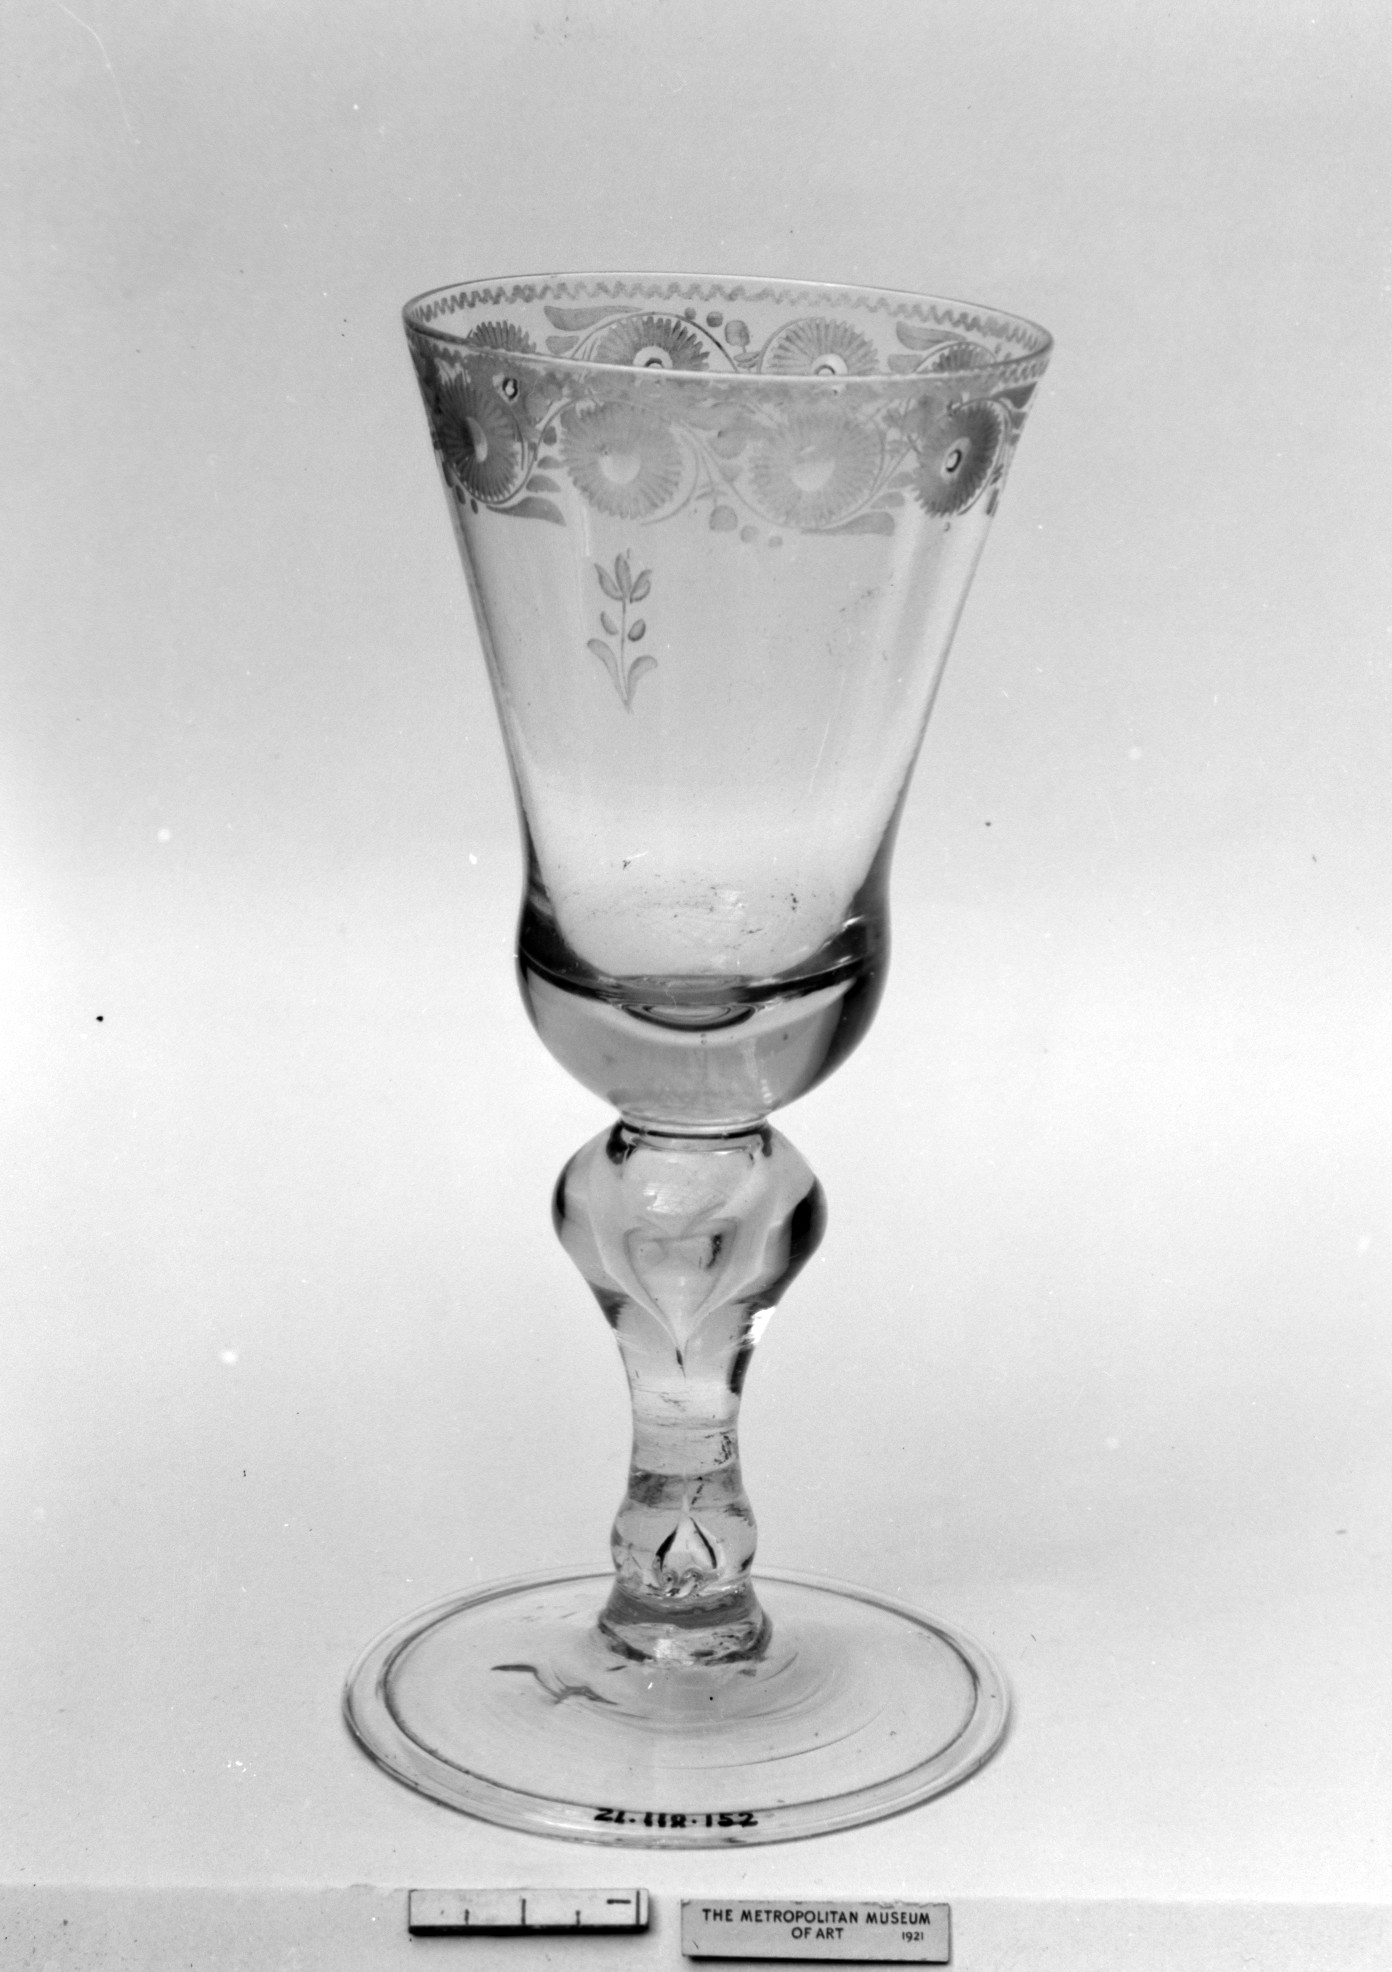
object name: wineglass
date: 1750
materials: glass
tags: flowers